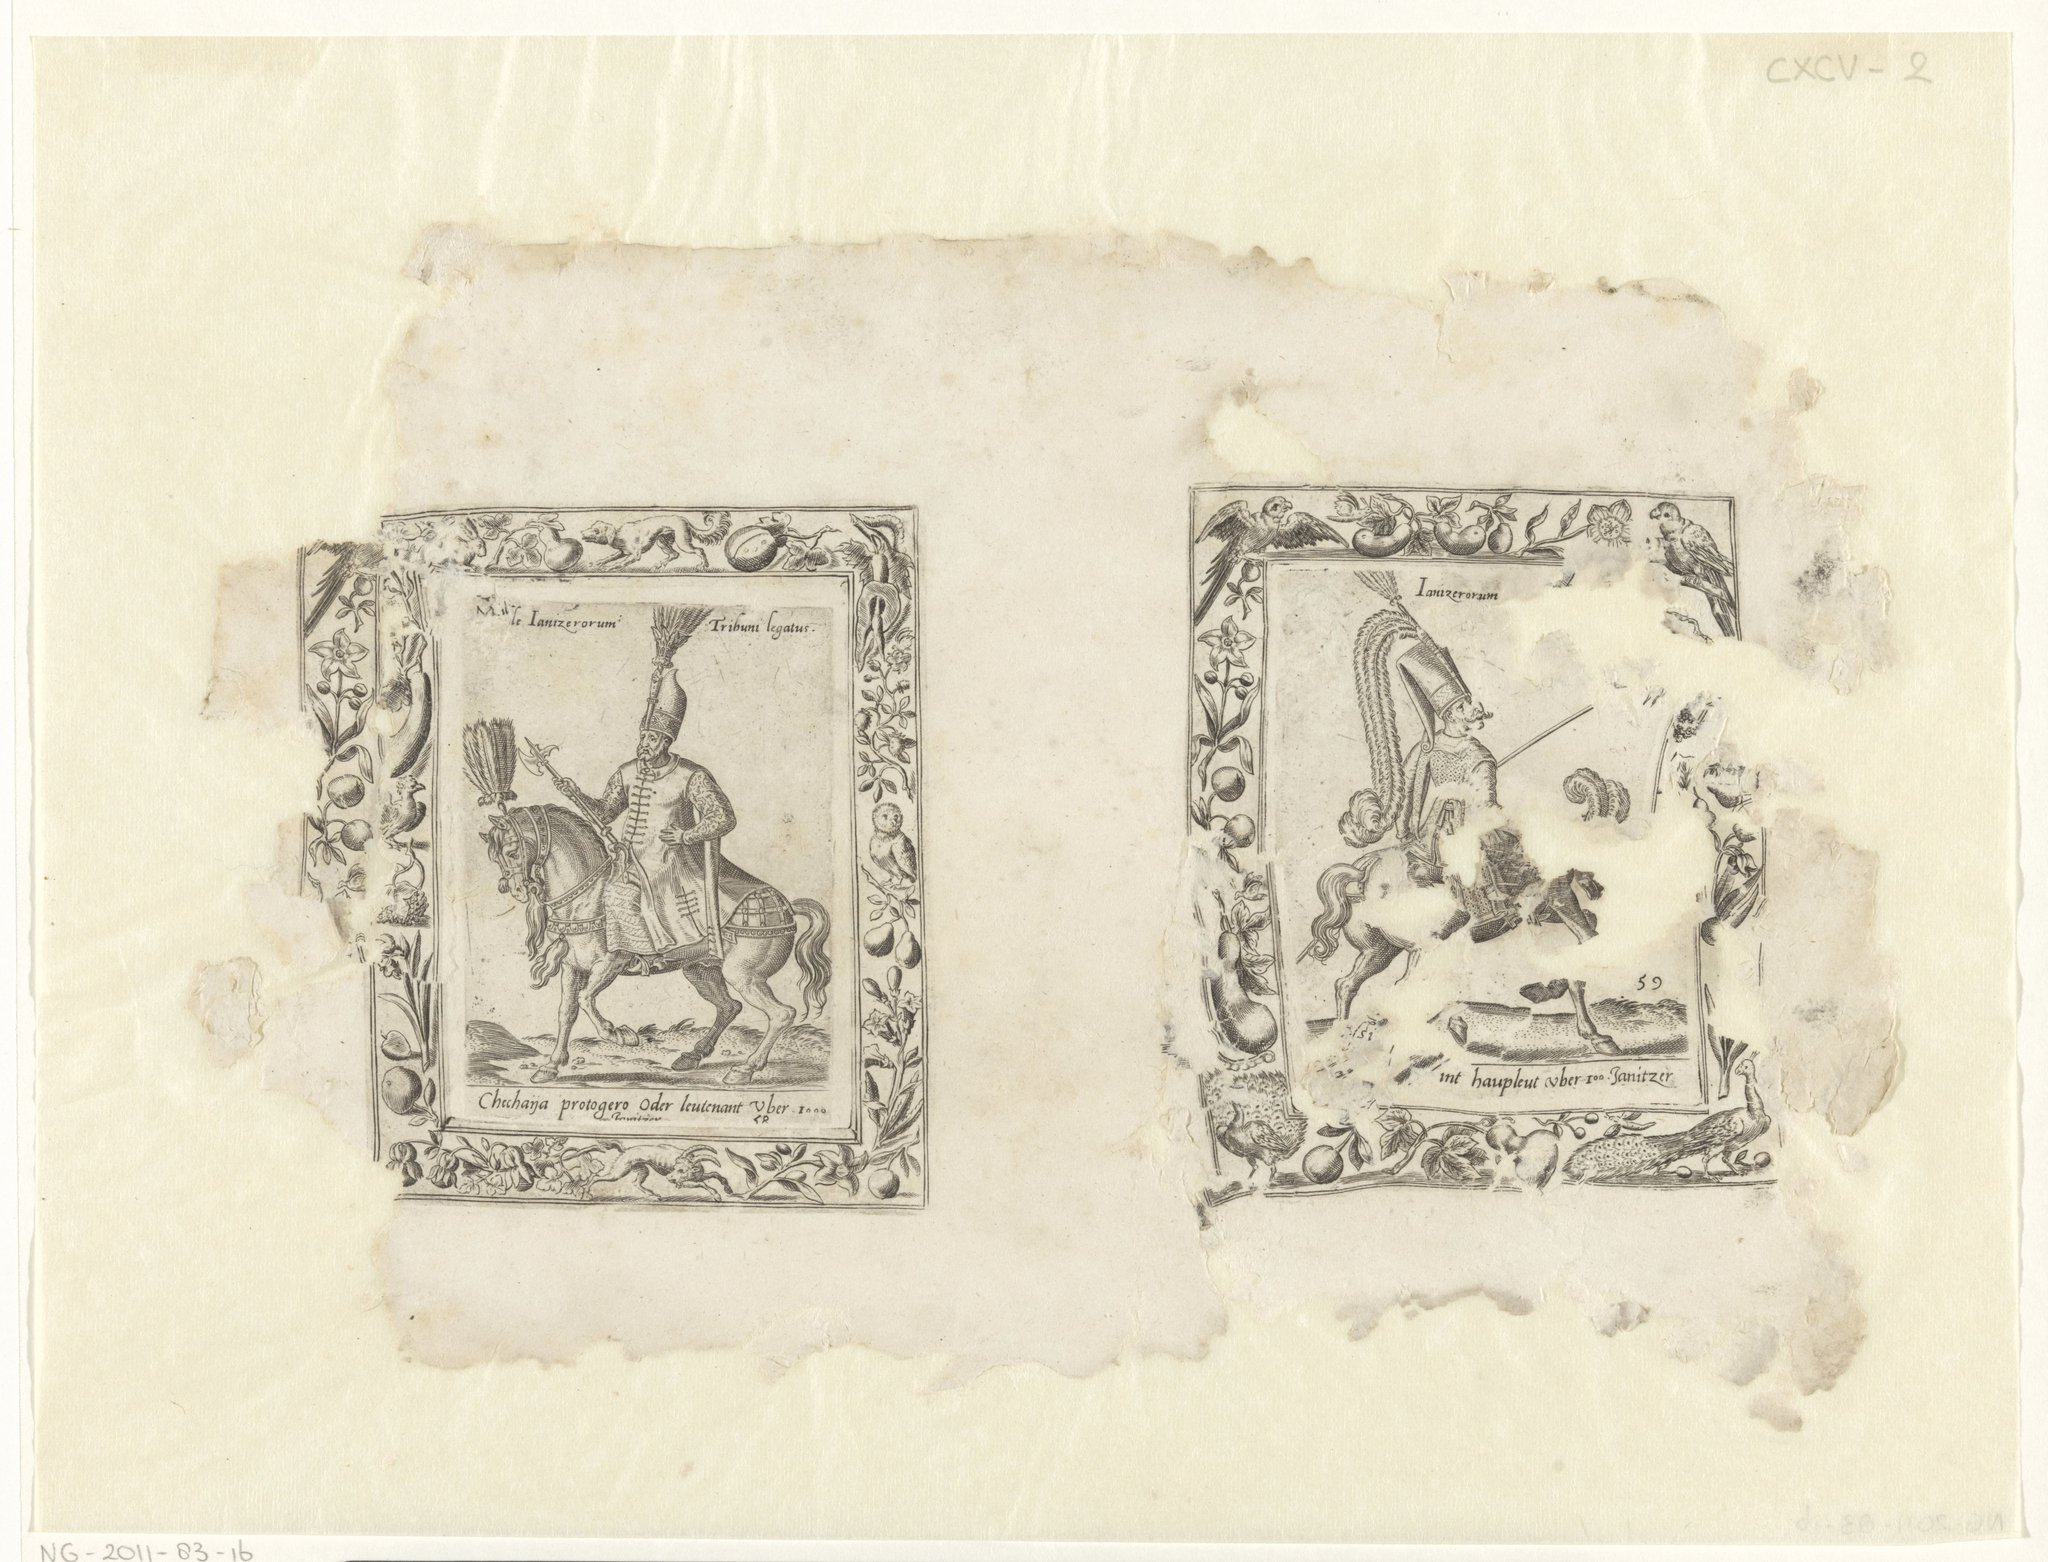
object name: costume print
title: Ruiterserie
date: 1576-1596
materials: paper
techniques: engraving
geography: cologne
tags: warfare; military affairs (+ cavalry, horsemen), folk costume, regional costume, military clothing and other equipment (uniforms, cap, armour, helmet, etc.)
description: Prent 58 en 59 uit een serie van 77, mogelijke serietitel Diversarum gentium armatura Equestris. Latere editie van serie Equitum Descripcio, Quomodo Equestres (...). De prenten in de Nova Zembla collectie zijn tijdens een expeditie van Willem Barendsz en Jacob van Heemskerk in 1596-1597 noodgedwongen in het winterkamp, het ‘Behouden Huis’, op het eiland achtergelaten. De prenten waren in één of meerdere stapels als handelswaar meegenomen vanuit Amsterdam. Bijna drie eeuwen later, in 1871, keerde de Noor Elling Carlsen terug naar Nova Zembla en vond daar de restanten van het ‘Behouden Huis, inclusief een groot deel van de inventaris. Een deel van de prenten, in de vorm van aaneengekoekte kluiten, werd toen ook teruggevonden. De papierkluiten waren soms op meerdere plekken gebroken. Tussen 1975-1979 zijn de prenten van elkaar gescheiden. Dit leverde in totaal ca. 1000 fragmenten van ca. 400 afdrukken van ca. 150 verschillende prenten op. Voor zover mogelijk zijn de fragmenten samengevoegd en zijn de prenten gereconstrueerd.